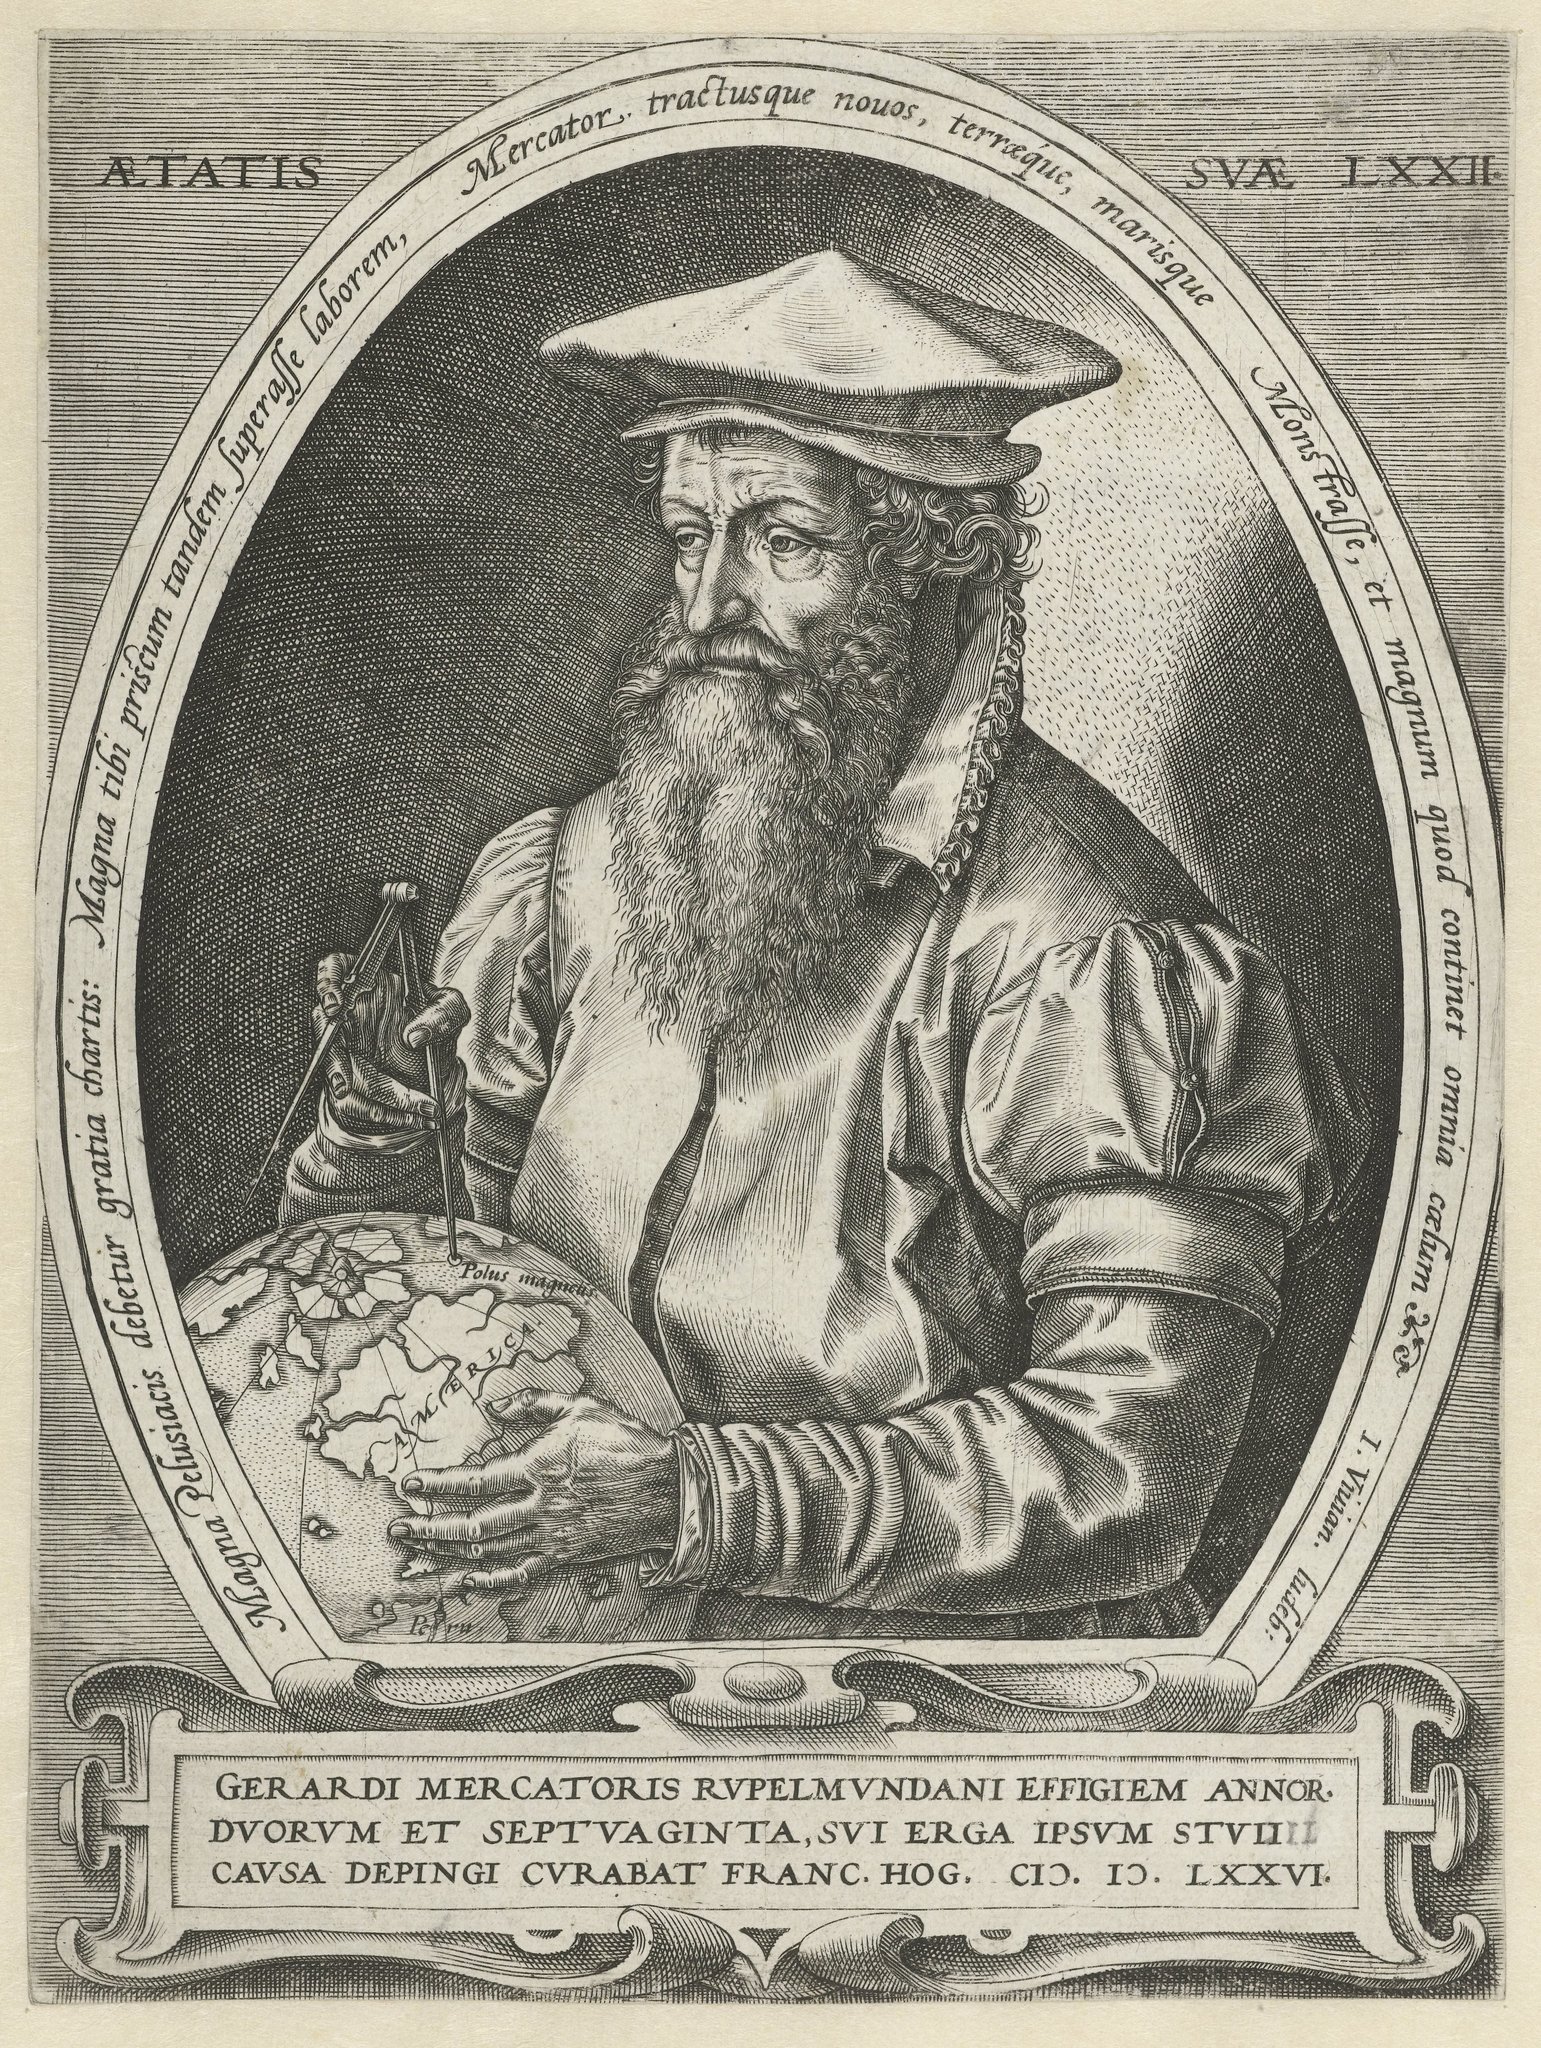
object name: print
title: Portret van Gerardus Mercator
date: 1576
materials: paper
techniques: engraving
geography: haarlem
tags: gerardus mercator, historical persons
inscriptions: collector's mark: Lugt 2228a, annotation: ‘Diverse aantekeningen over de verschillen tussen de staten.’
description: In de eerste staat is Mercator 72 jaar. Als deze leeftijd correct is, klopt de datering (1576) niet. In de tweede staat is de leeftijd gecorrigeerd in 64 en blijft de datering onveranderd. In de derde staat is Mercator twee jaar jonger geworden (62) en is de datering aangepast tot 1574. Er bestaat twijfel of dit portret van Mercator daadwerkelijk van Goltzius' hand is (zie documentatie: Leeflang 2003). Jacobs, G.